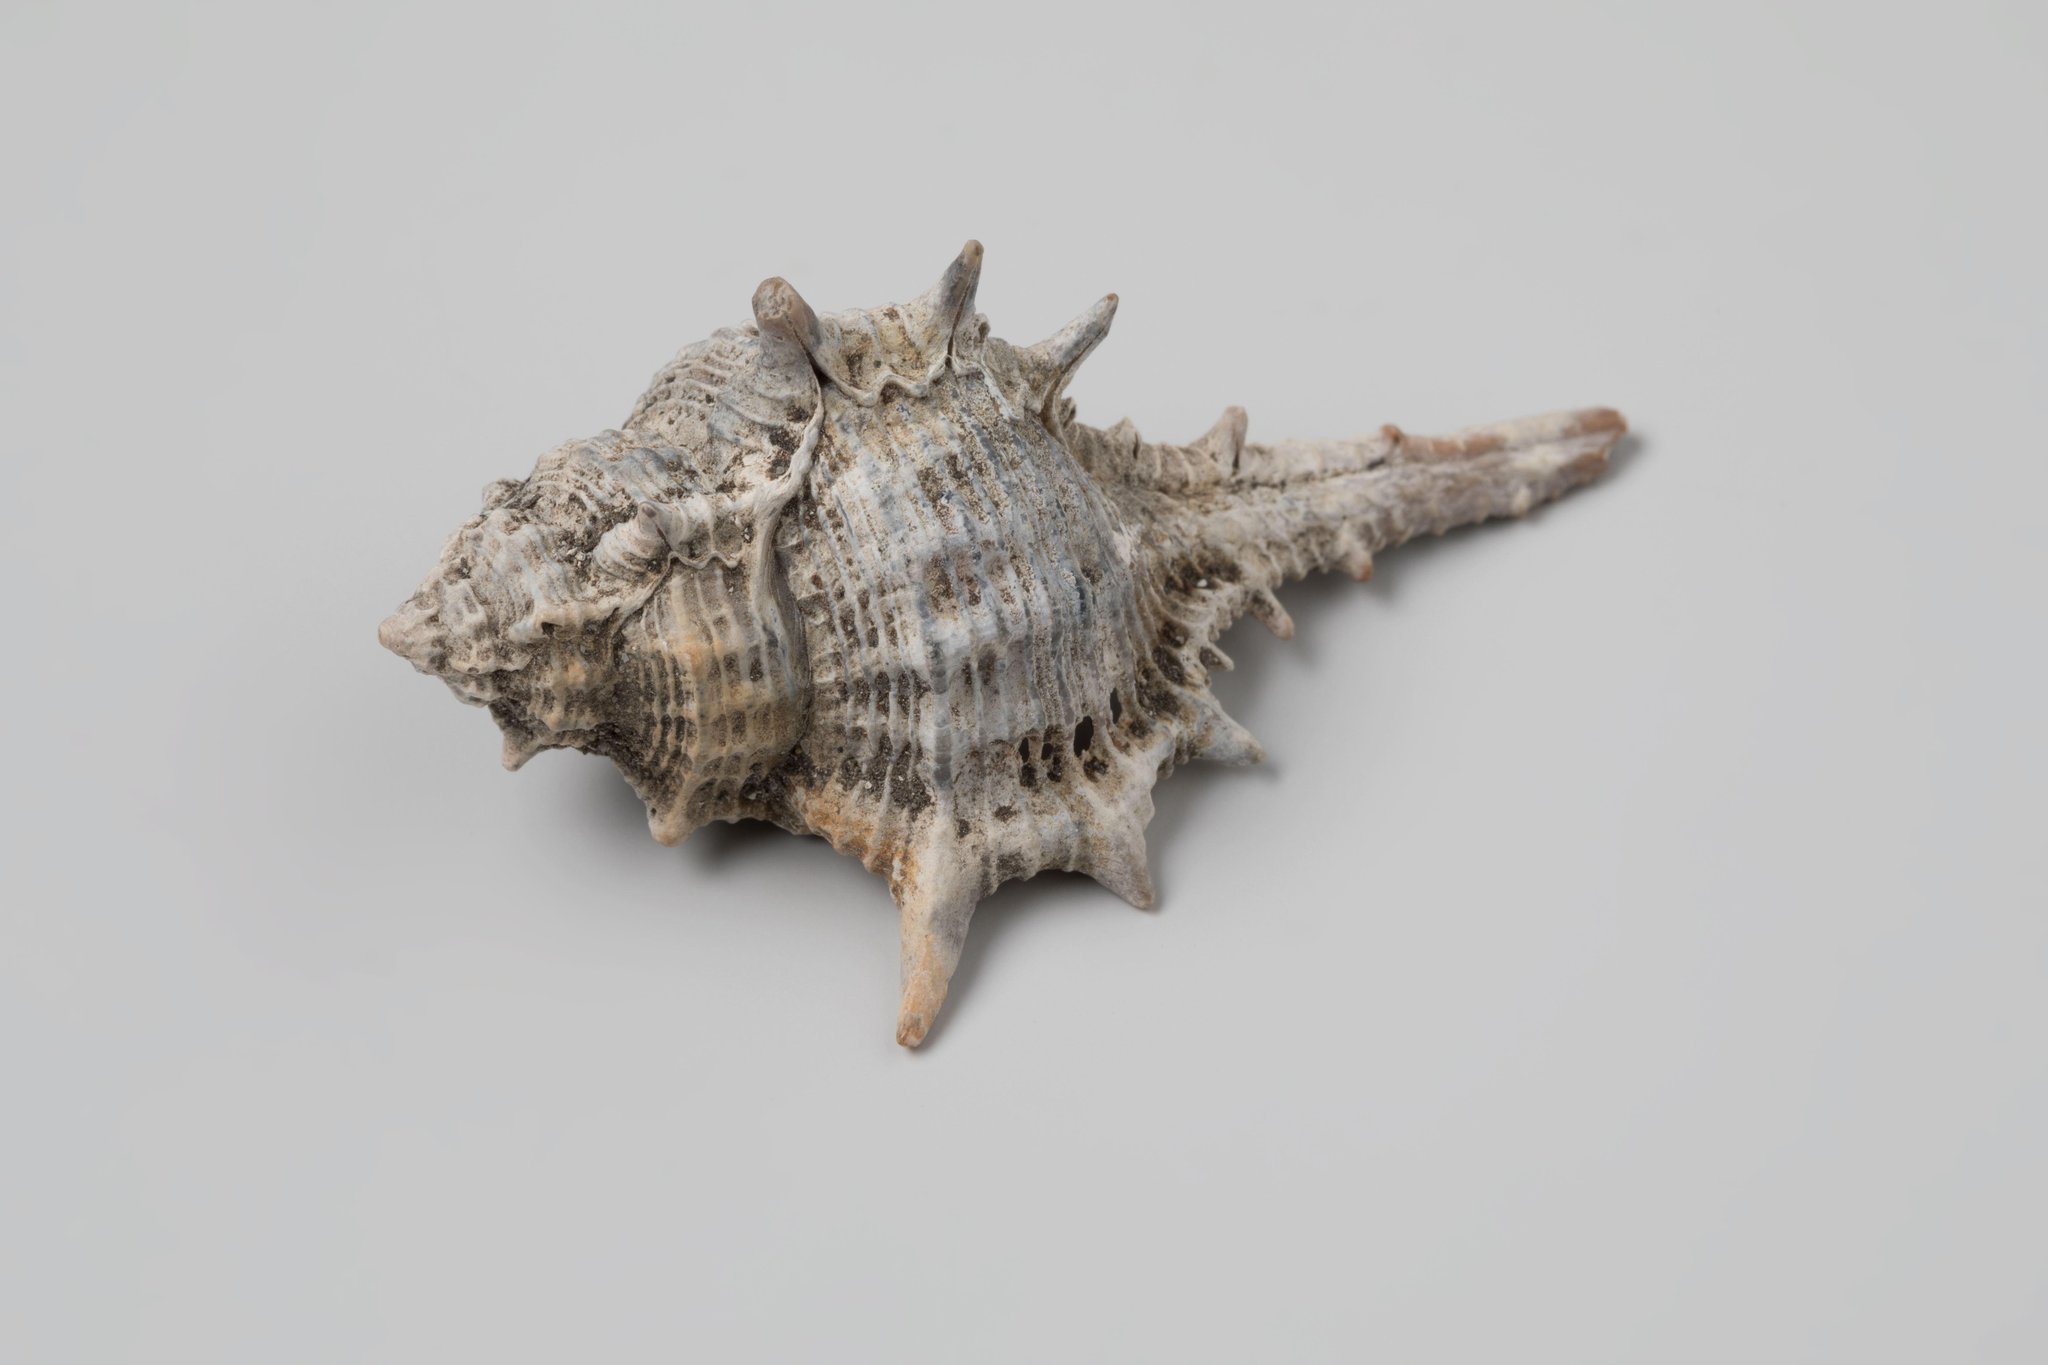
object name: murex ternispina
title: Murex ternispina shell from the wreck of the Dutch East India ship Witte Leeuw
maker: niet van toepassing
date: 1613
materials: shell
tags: verenigde oostindische compagnie, sint-helena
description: Schelp uit V.O.C.-schip de 'Witte Leeuw'.